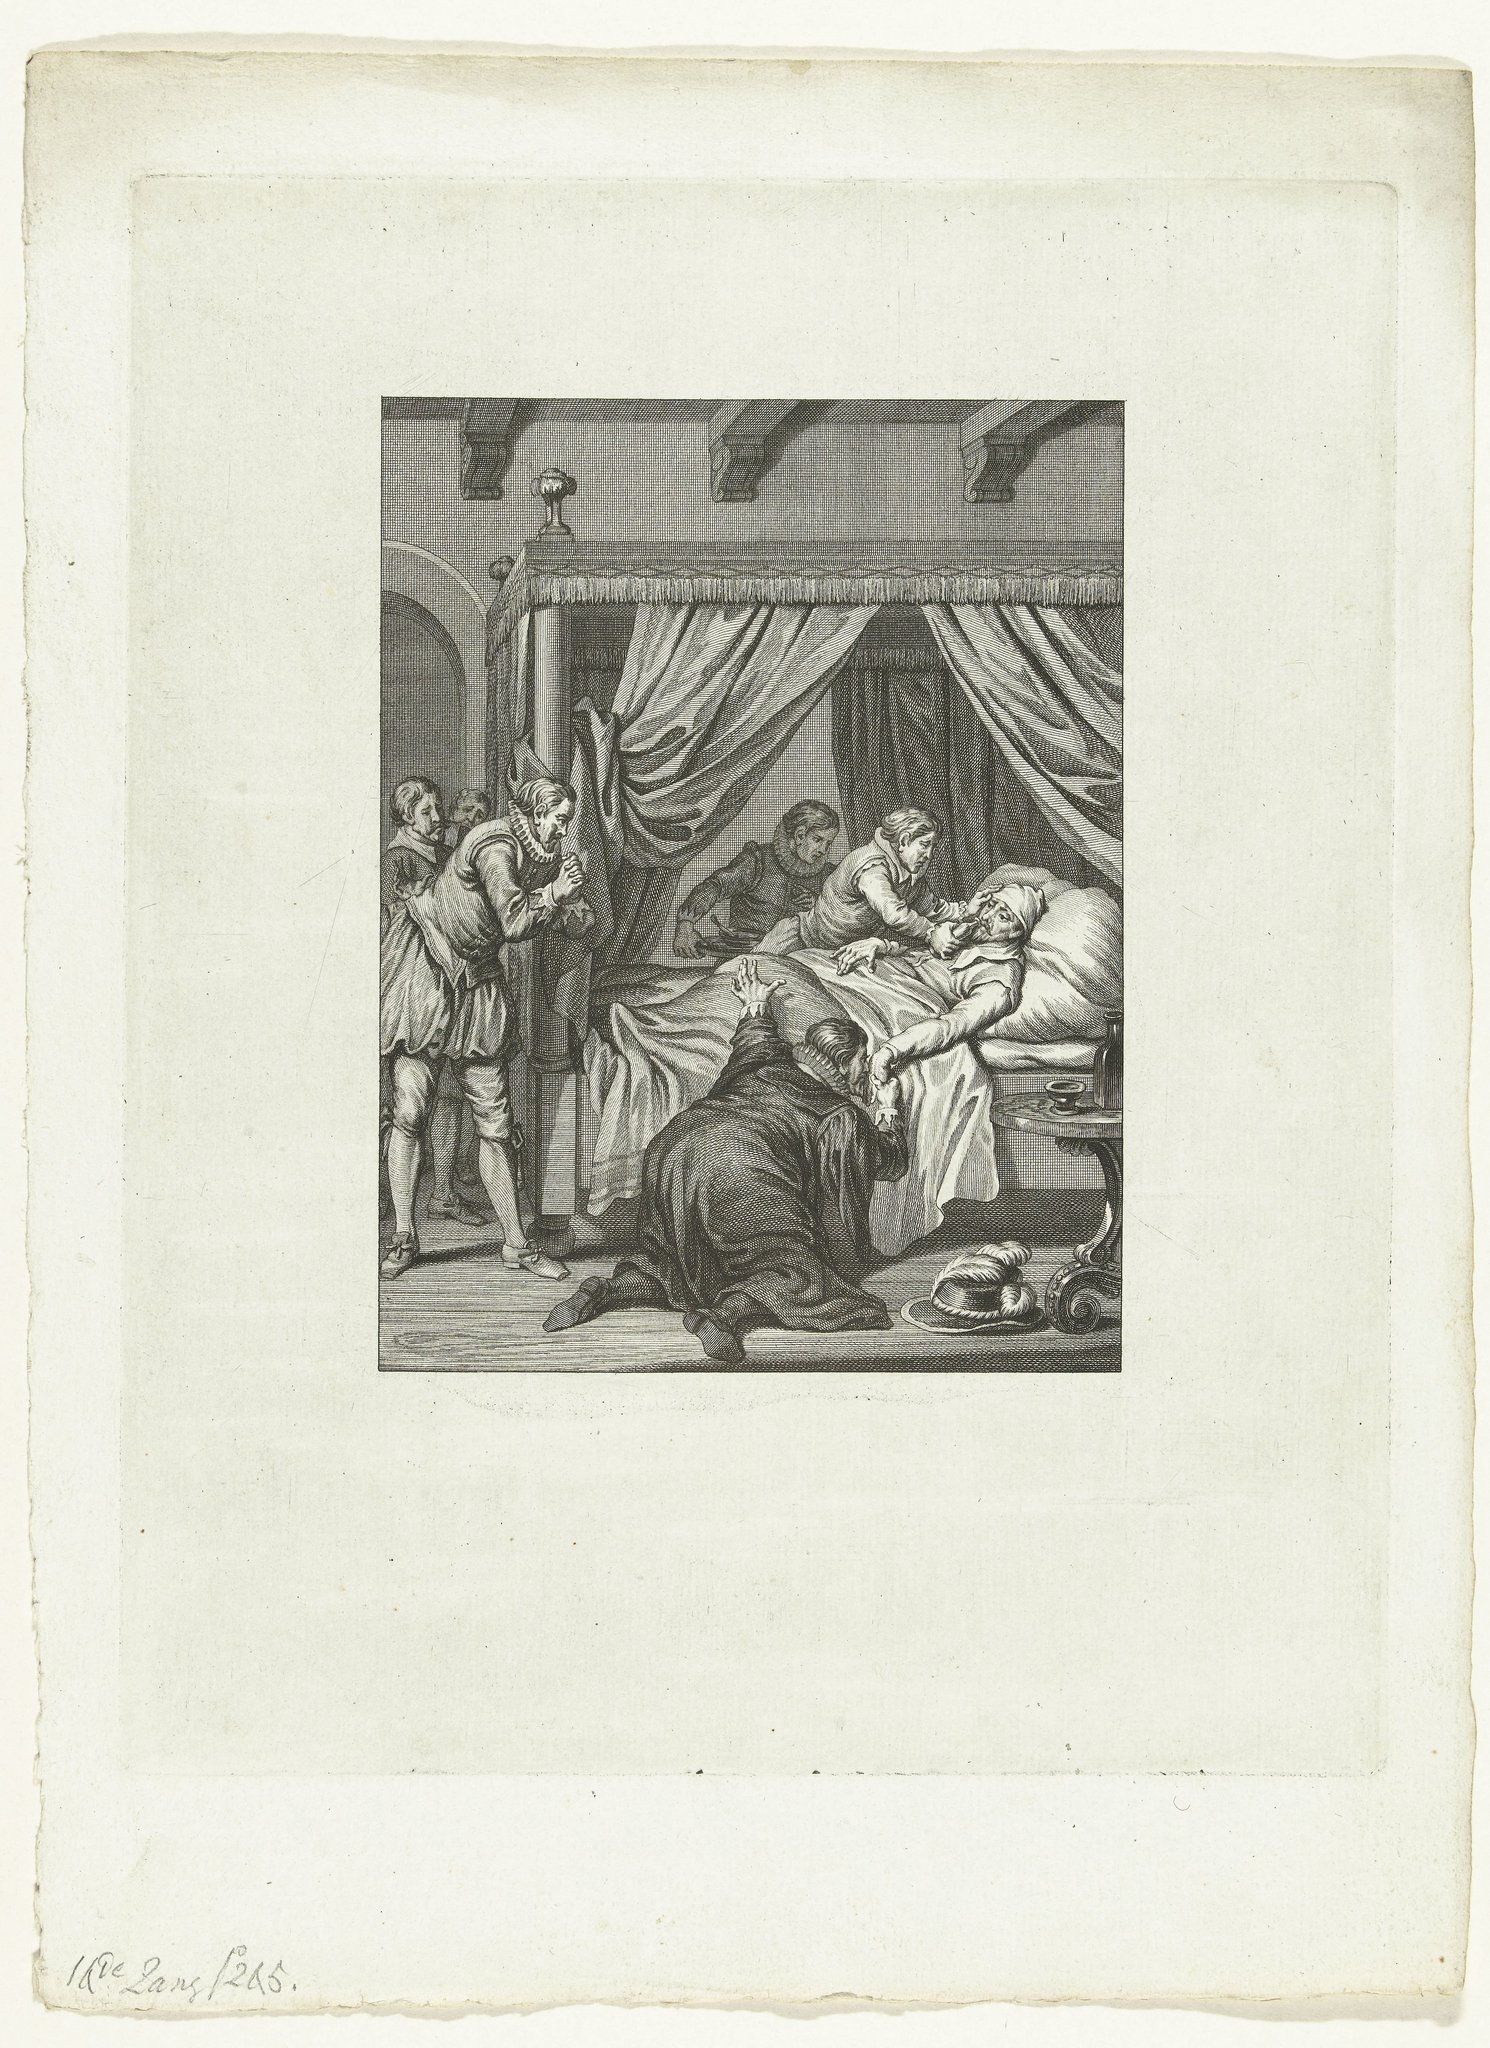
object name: print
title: Ziekbed van de prins, 1574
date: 1782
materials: paper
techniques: etching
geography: amsterdam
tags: delft, william i (prince of orange), politician, filips van marnix van sint-aldegonde, visiting the sick; sick person together with others, rotterdam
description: Illustratie voor: J. Nomsz, Willem de eerste, of de grondlegging der Nederlandsche vryheid. : In vier en twintig zangen, Erven van David Klippink, Amsterdam 1779. Staat vóór de letter. Groep van vier proefdrukken in de oorspronkelijke omslag van de uitgevers J. Smit, W. Vermandel en J.W. Smit te Amsterdam, 1782 (de vierde uitgave).